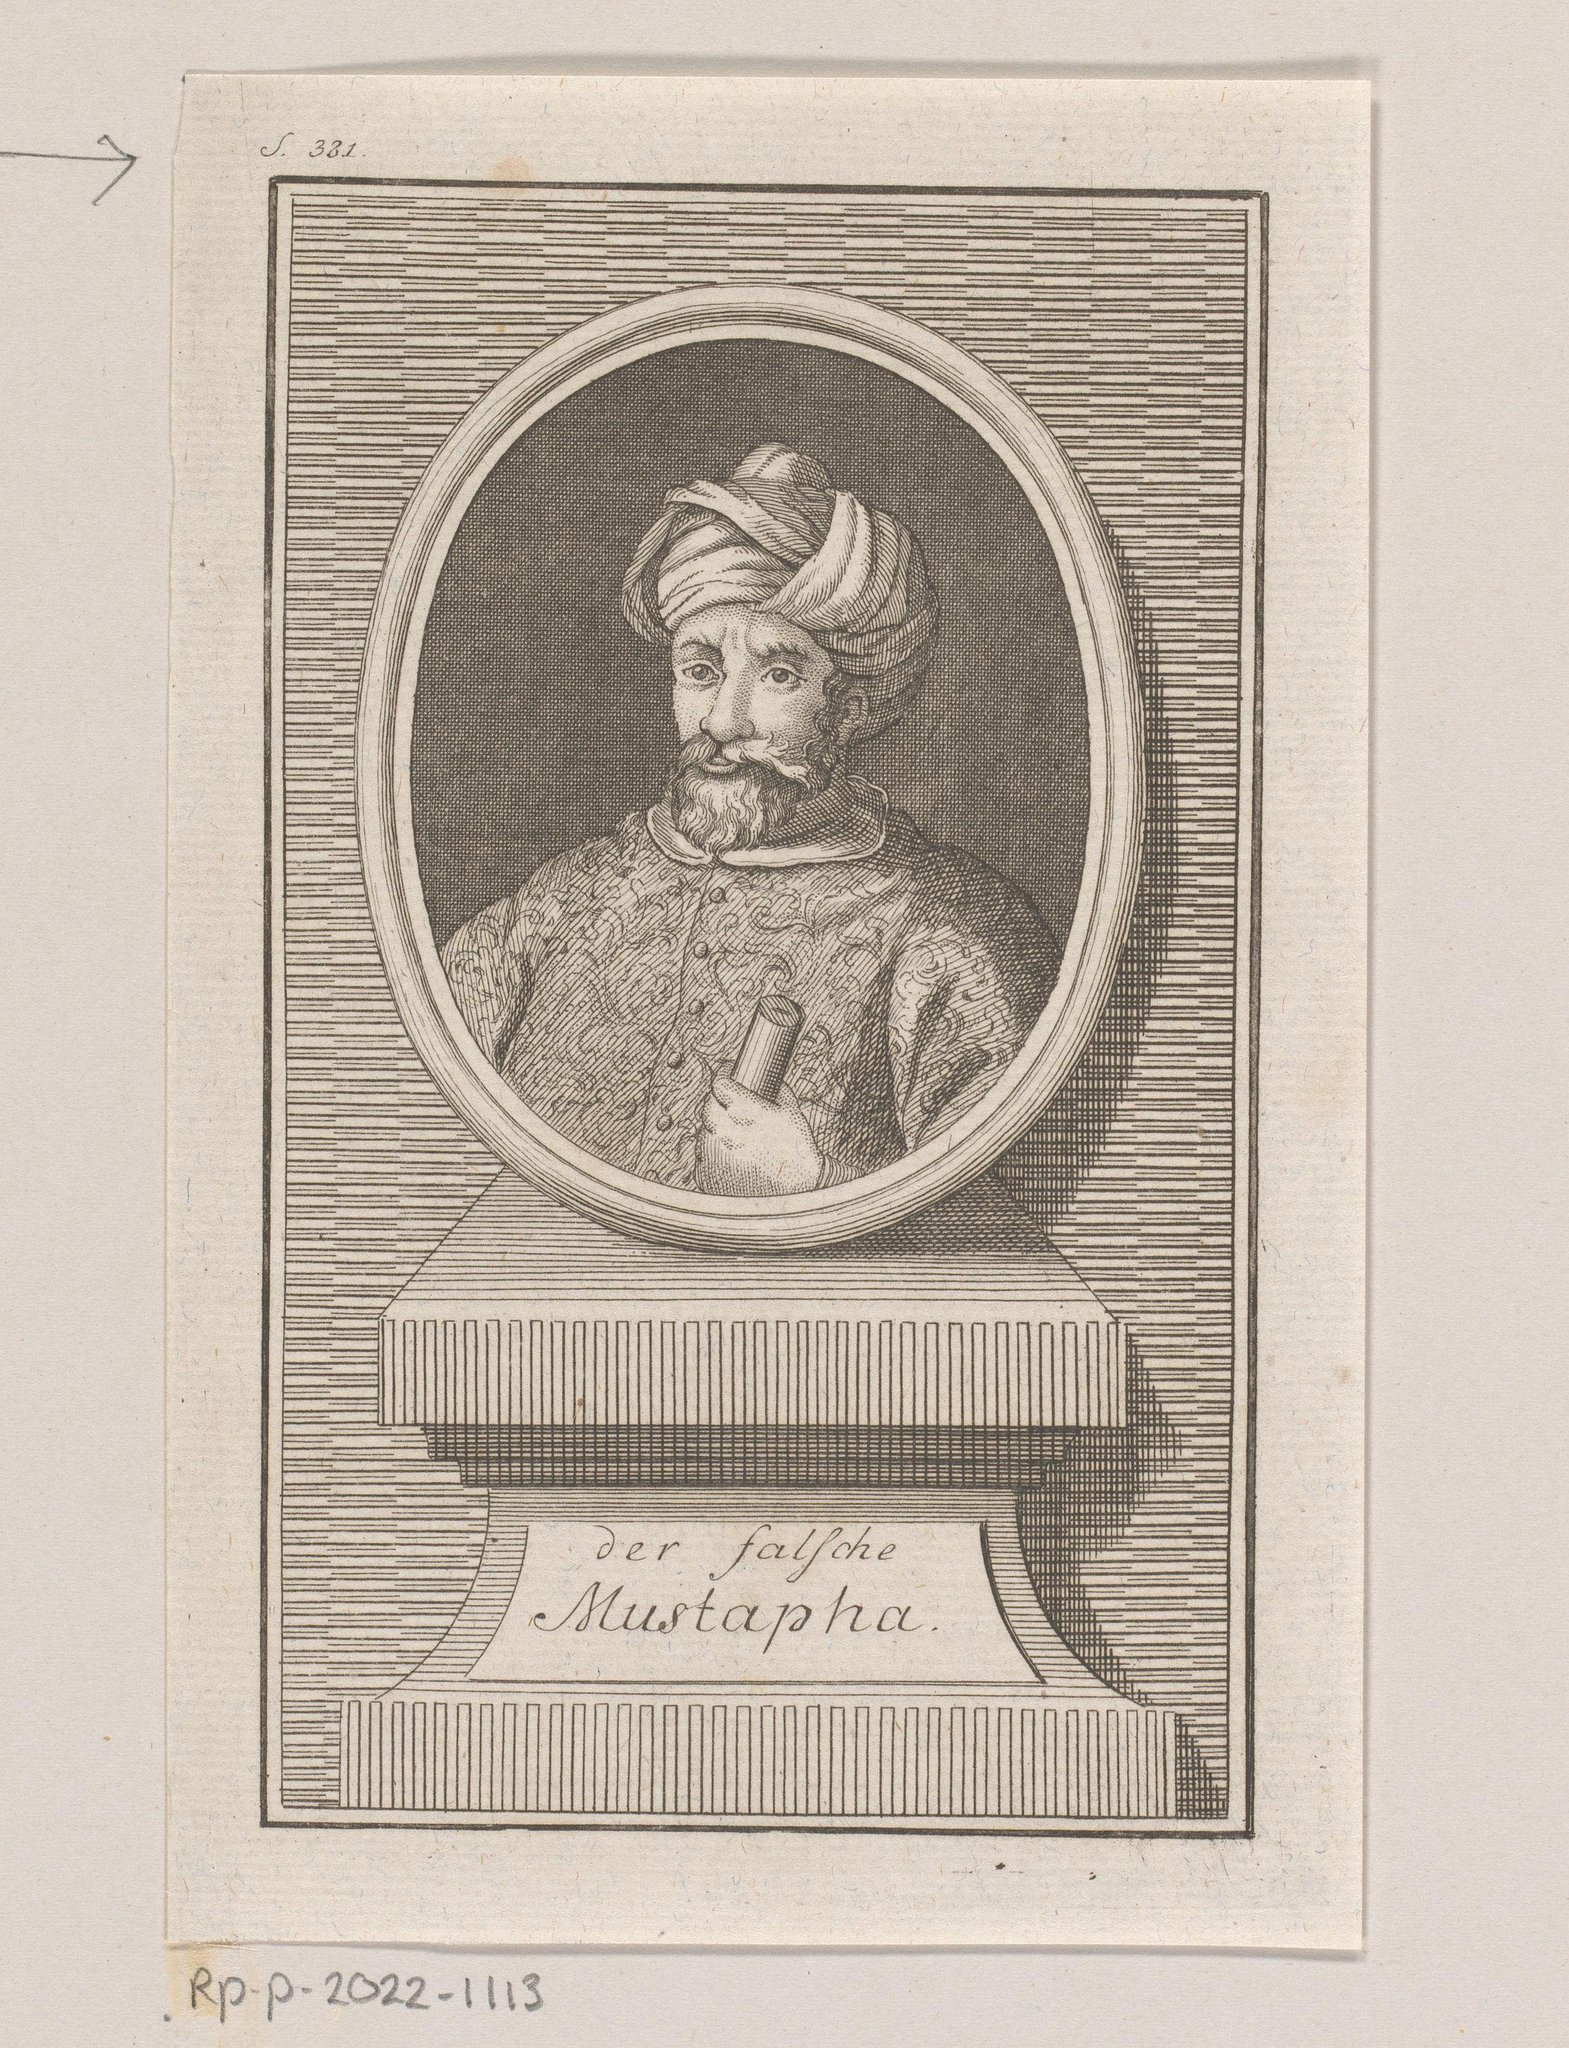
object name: print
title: Portret van Mustafa Çelebi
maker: Anonymous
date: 1760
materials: paper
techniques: etching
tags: historical persons, head-gear: turban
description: Prent waarschijnlijk uit: Rocoles, Jean-Baptiste de, Karl Friedrich Pauli en Johann Ludwig Schutze. Joh. Baptista von Rocoles, Königl. Französischer und Churfürstl. Brandenburgischer Geschichtschreiber, Begebenheiten ausnehmender Betrüger. Halle: Christoph Peter Francken, 1760.